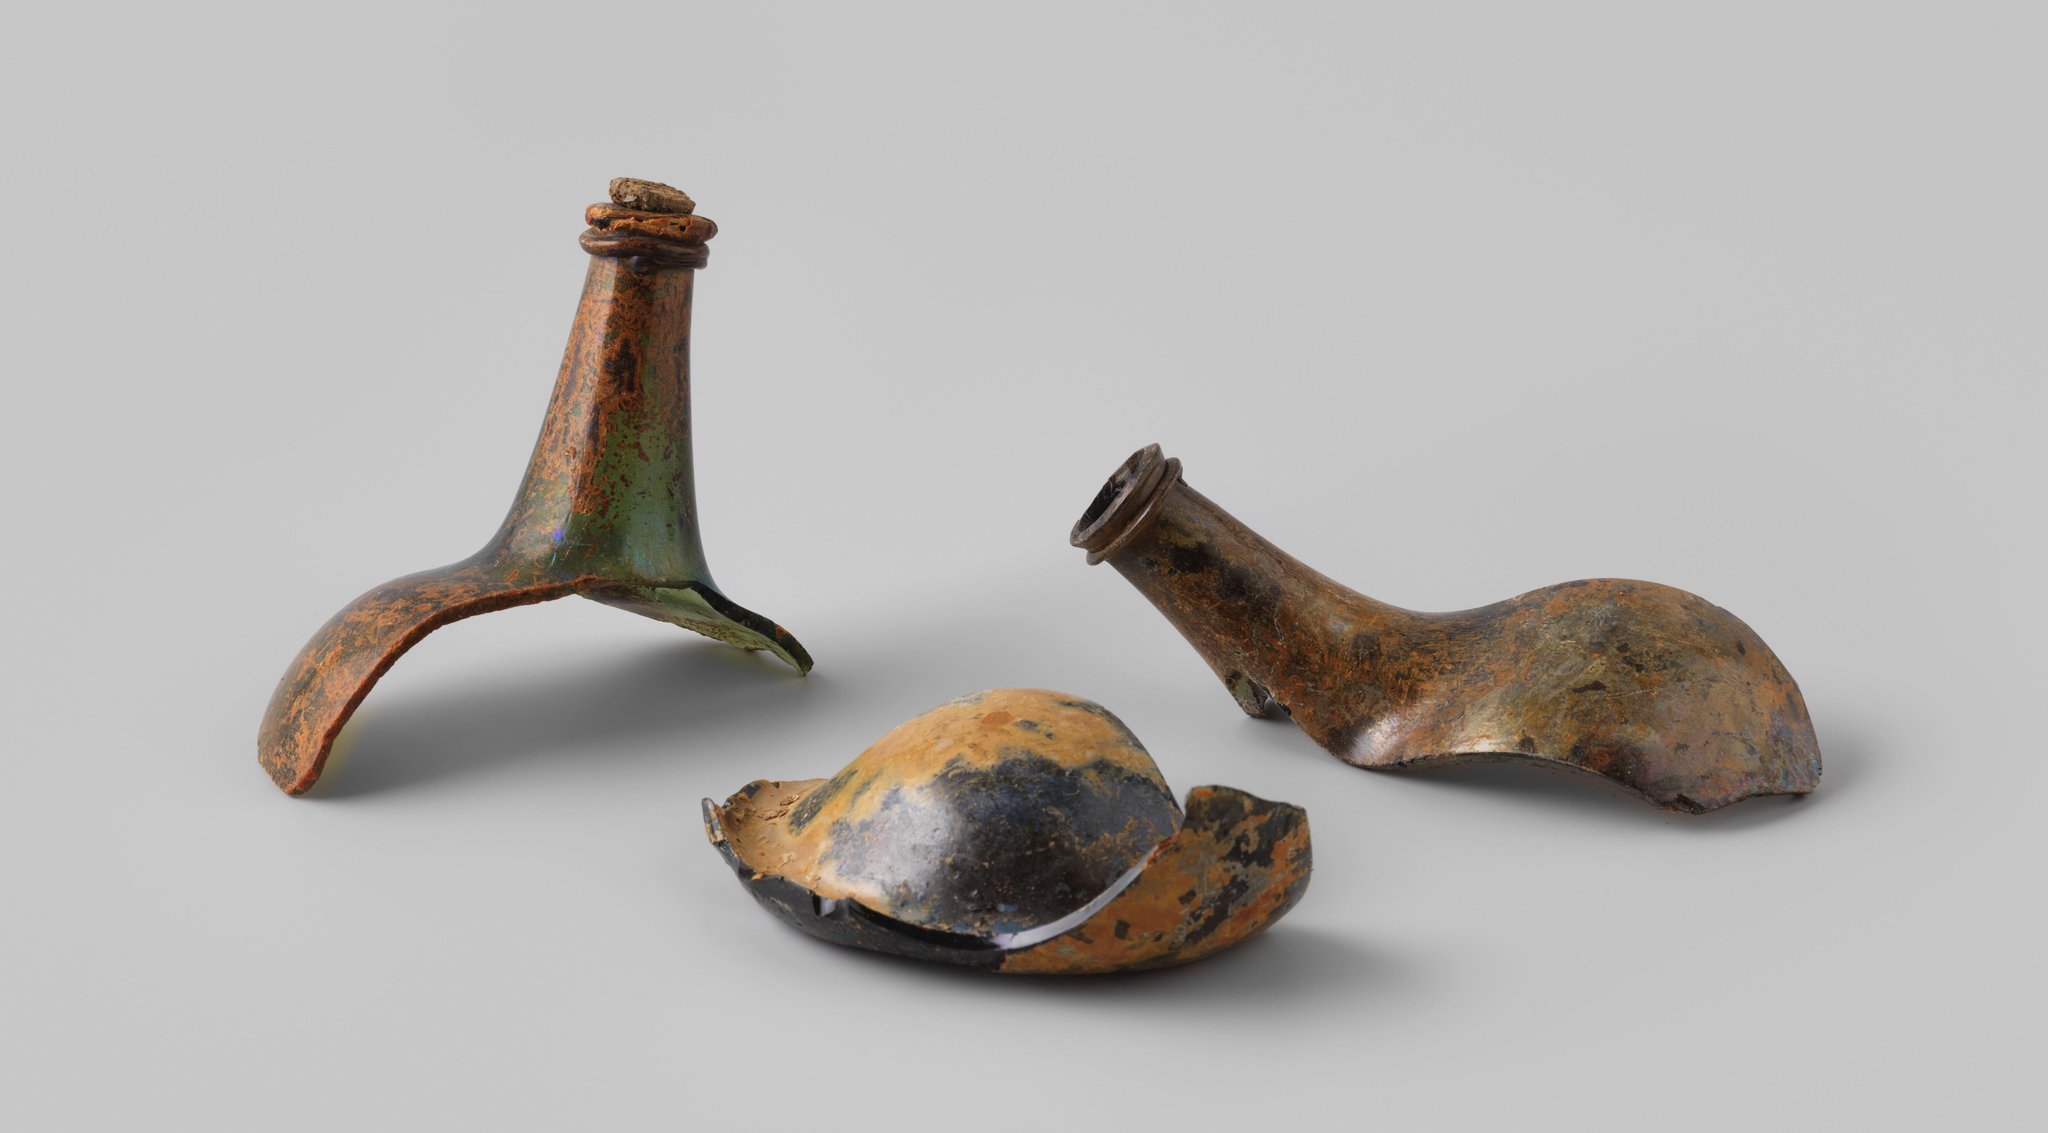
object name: wine bottle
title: Scherven van wijnflessen uit het wrak van de Oost-Indiëvaarder 't Vliegend Hart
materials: cork, glass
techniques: green glass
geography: netherlands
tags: 't vliegend hart (schip), verenigde oostindische compagnie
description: Scherven van uivormige wijnflessen van groen glas waar rode (port)wijn in heeft gezeten. Hals met kurk.